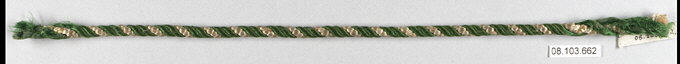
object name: cord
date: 1701-1900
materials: silk